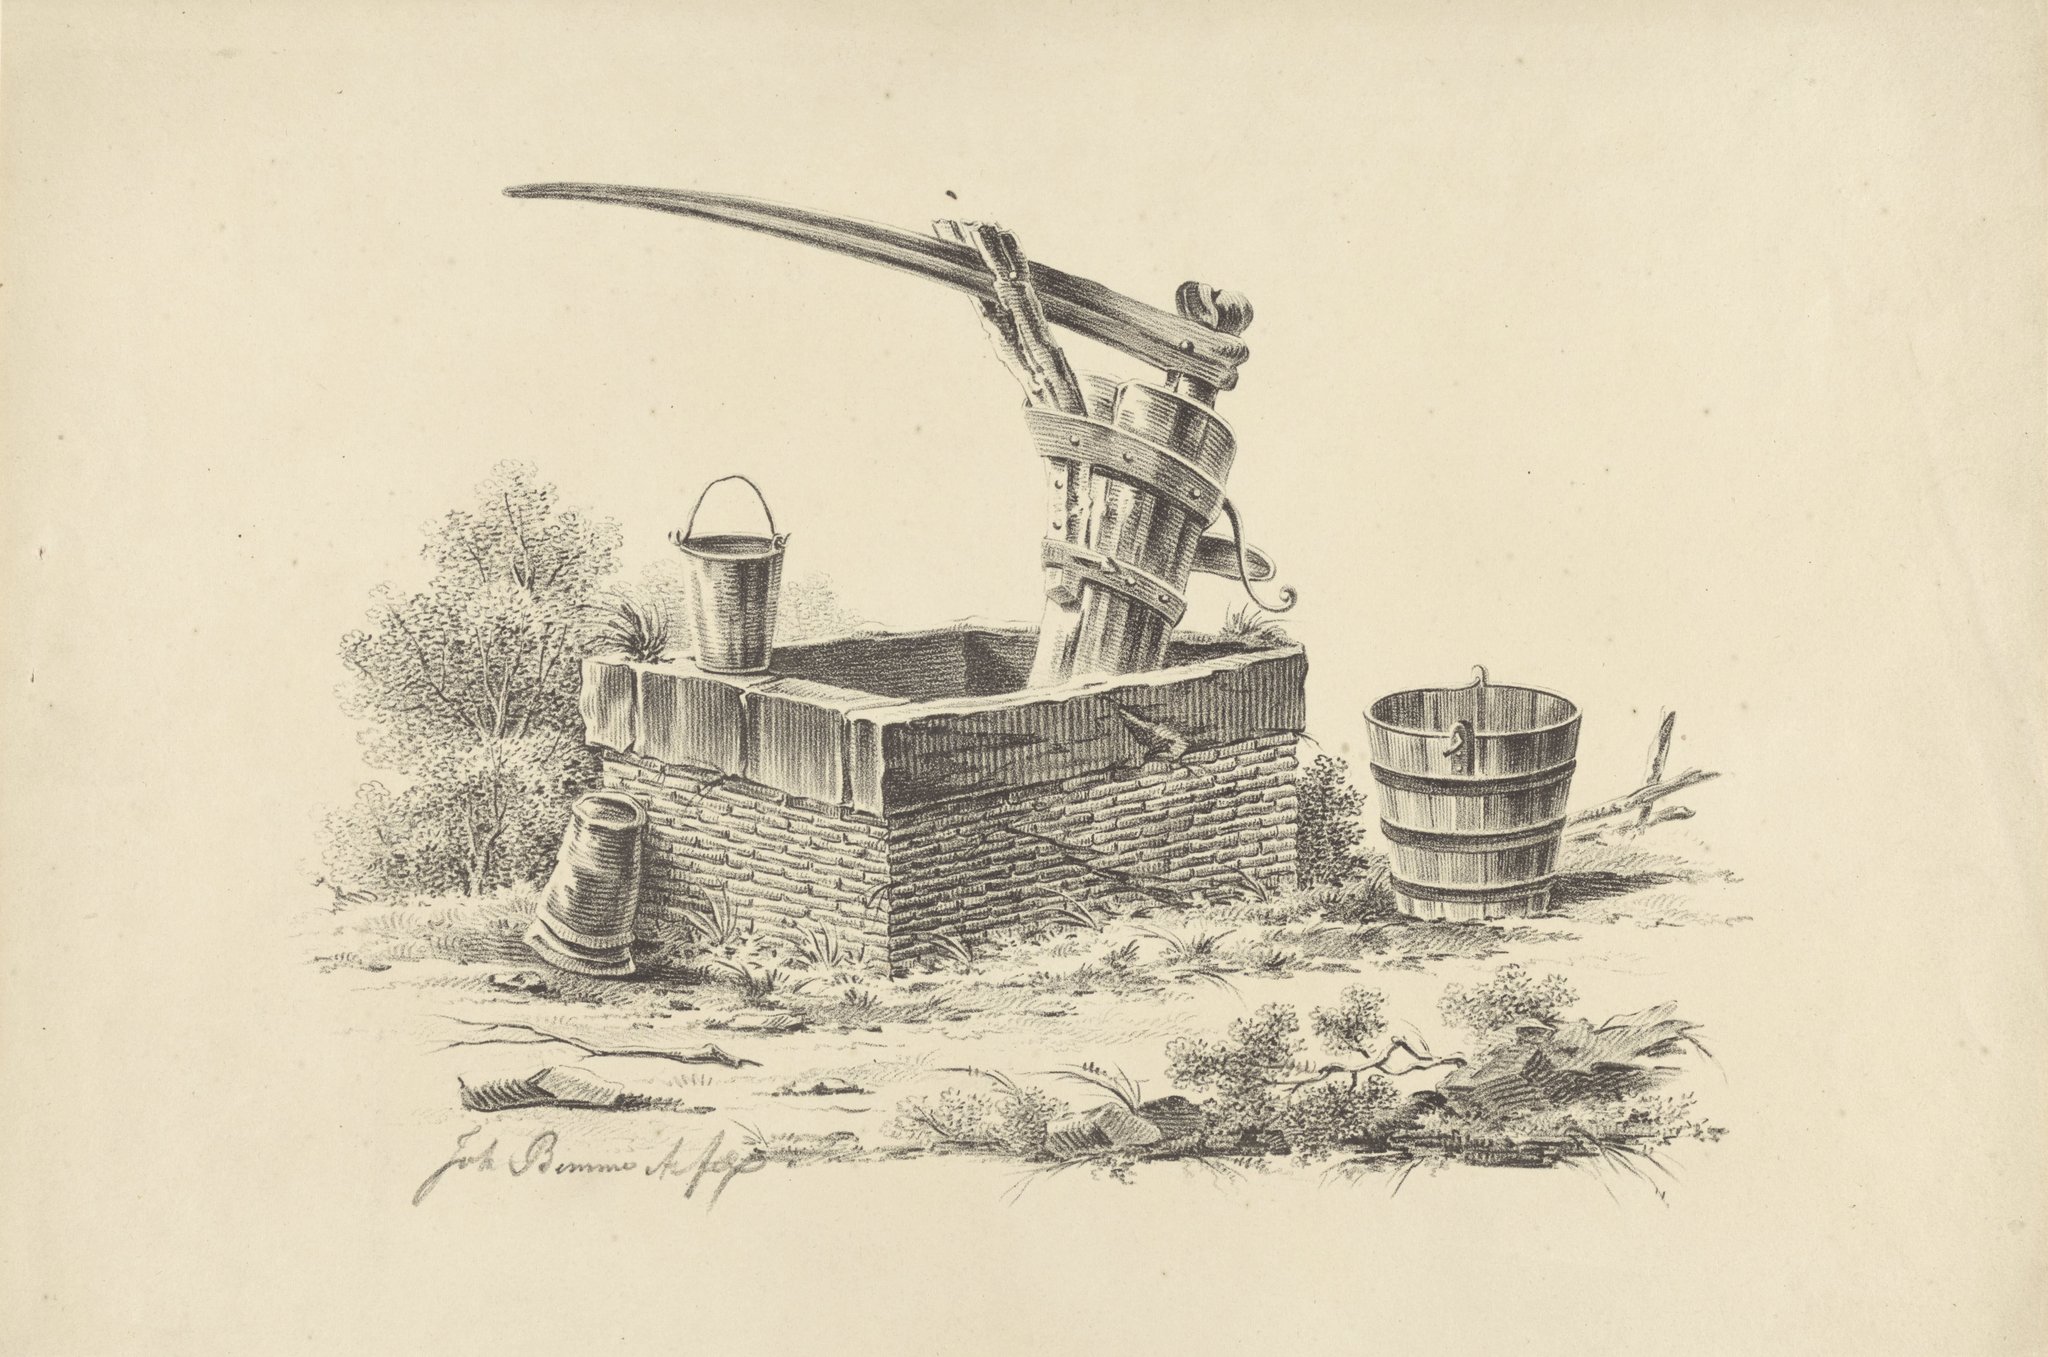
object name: print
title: Houten pomp in vierkante put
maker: joannes bemme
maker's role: print maker, printer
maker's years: 1775-1841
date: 1809-1841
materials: paper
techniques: lithograph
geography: netherlands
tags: well, wooden container: barrel, cask, bucket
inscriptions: collector's mark: Lugt 2228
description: Op de rand van de put en ernaast staan drie emmers.